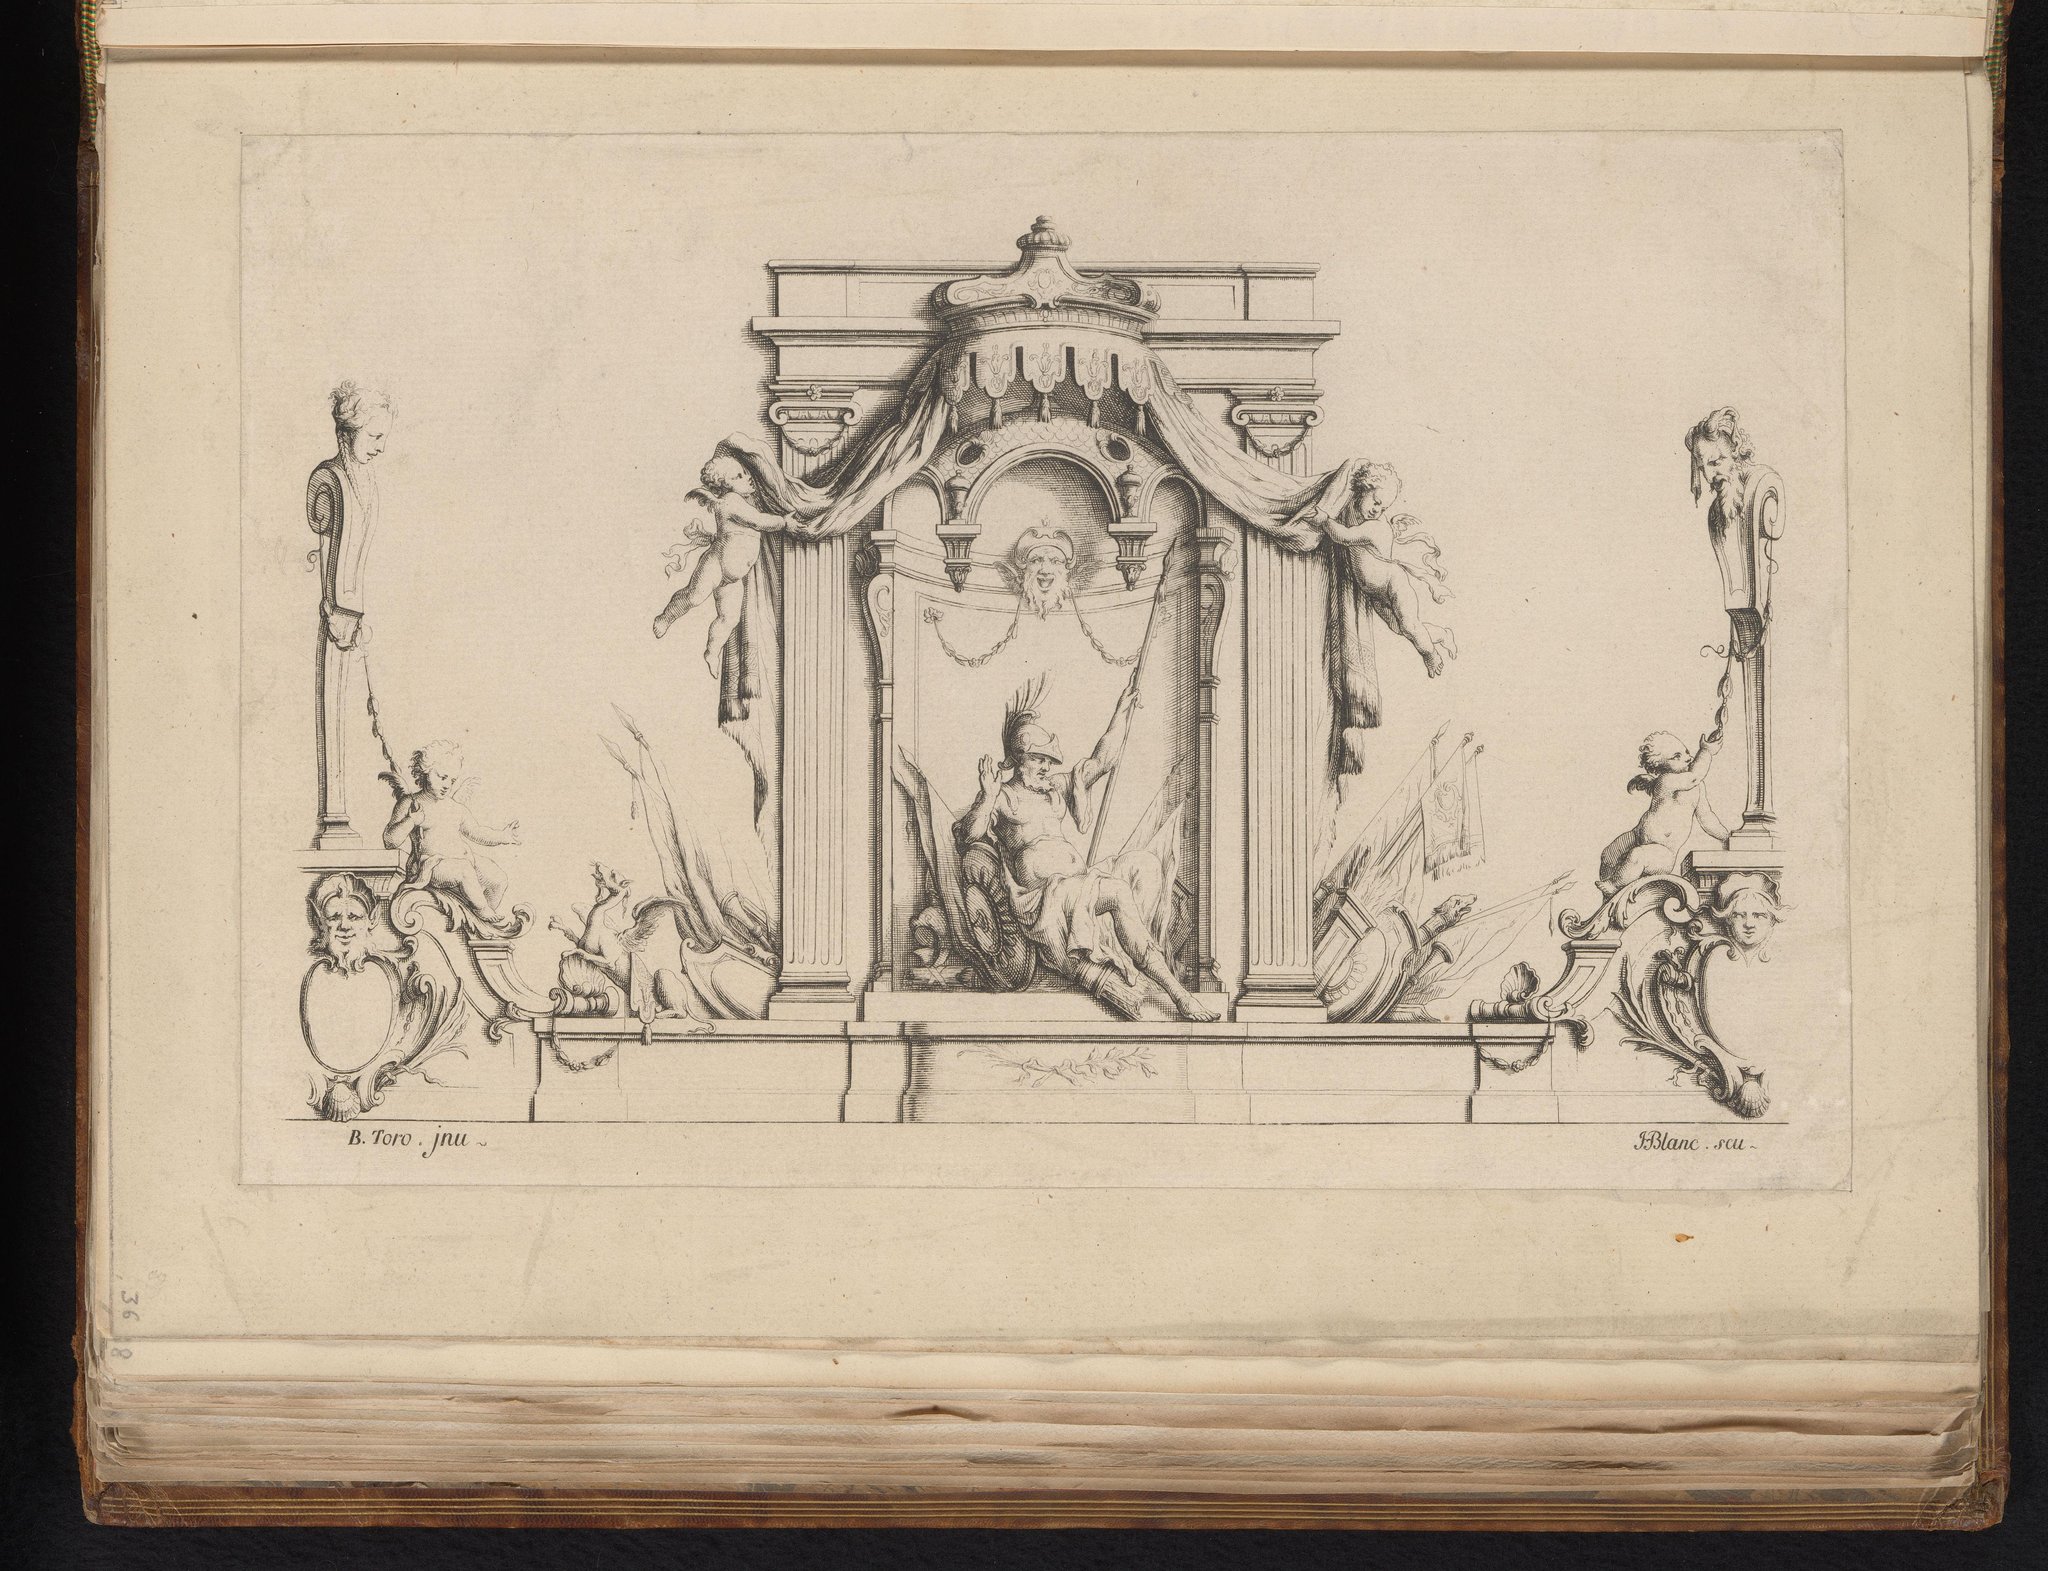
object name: ornament print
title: Ornamenten met de triomftochten van Venus en Pan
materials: paper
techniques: etching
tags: (story of) mars (ares), 'tropaion', i.e. decorative ornament ~ weapons, weapons, other hybrid forms in the shape of a pillar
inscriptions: collector's mark: Lugt 2760, collector's mark: Lugt 2228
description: Prent maakt deel uit van een serie van zes prenten.